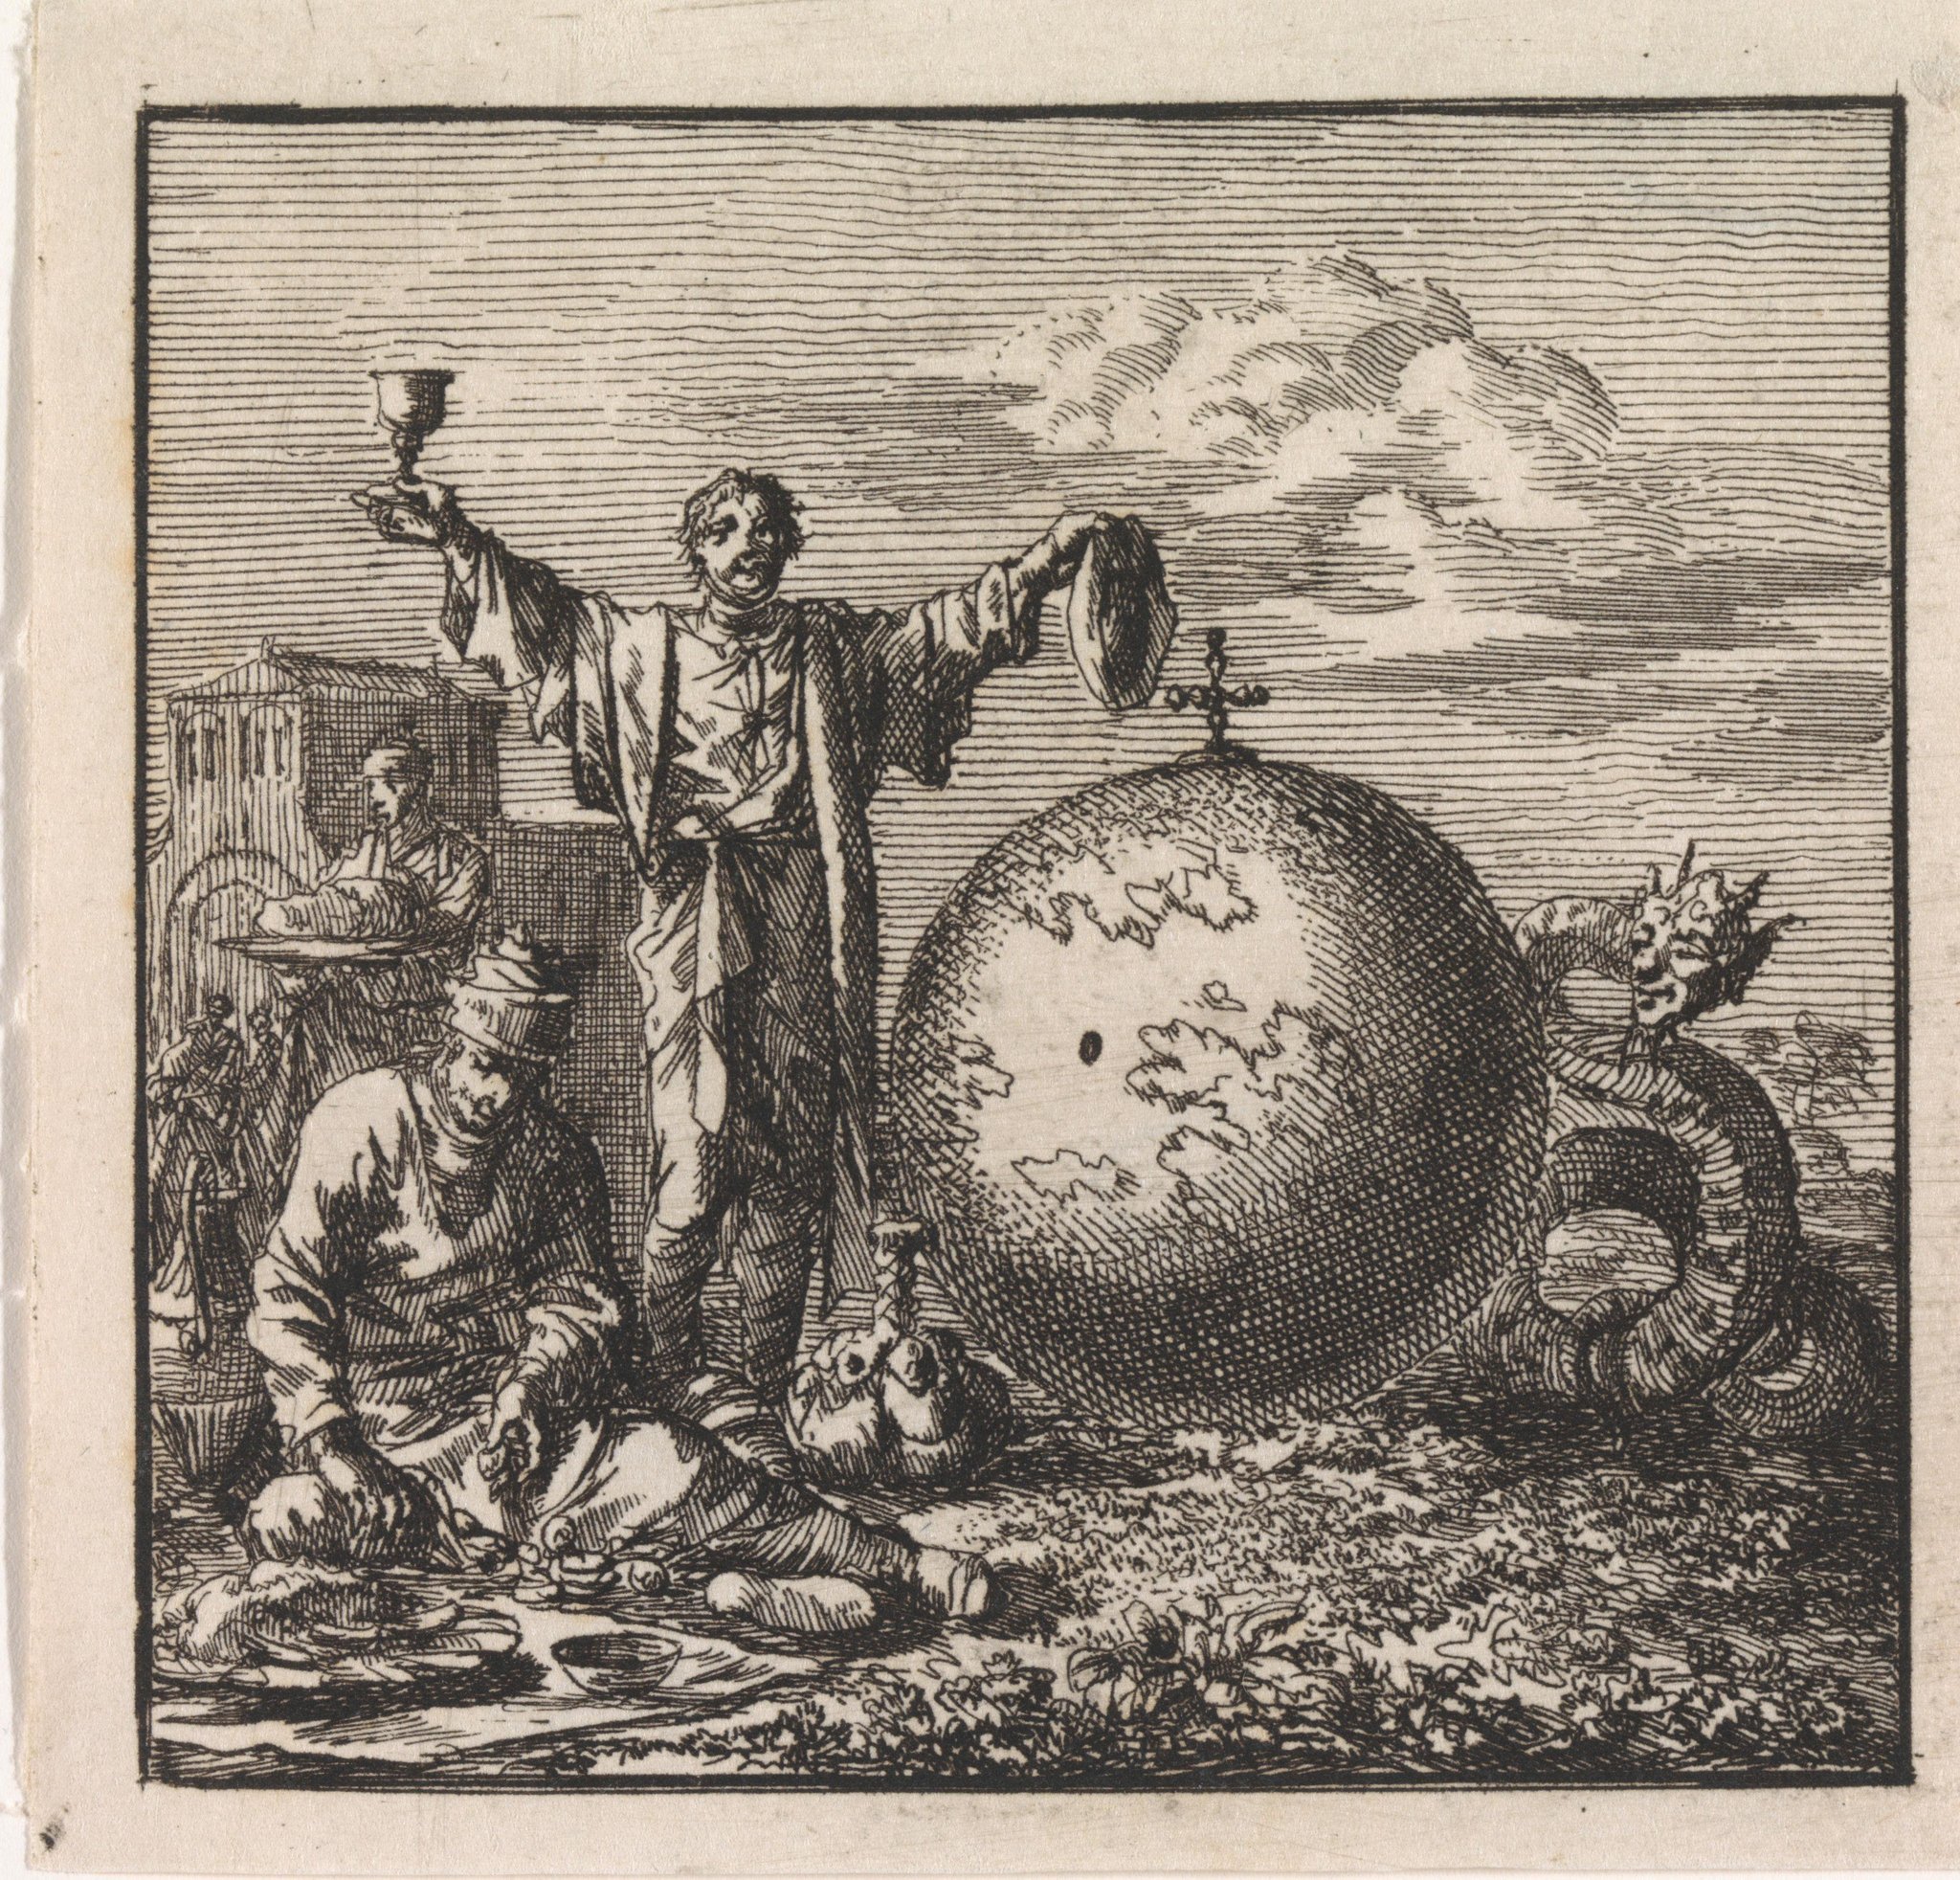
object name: print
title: Twee mannen genieten van drank en voedsel terwijl Satan vanachter de wereldbol toekijkt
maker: jan luyken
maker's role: draughtsman, print maker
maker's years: 1649-1712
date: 1710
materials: paper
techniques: etching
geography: amsterdam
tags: earth, world as celestial body, devil(s) and demons: satan, eating and drinking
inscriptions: collector's mark: Lugt 2228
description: Proefdruk voor illustratie uit: Luyken, Jan. De onwaardige wereld, vertoond in vyftig zinnebeelden, met godlyke spreuken en stichtelyke verzen. Amsterdam: Pieter Arentsz. II (wed.) en Cornelis van der Sys, 1710, p. 176.